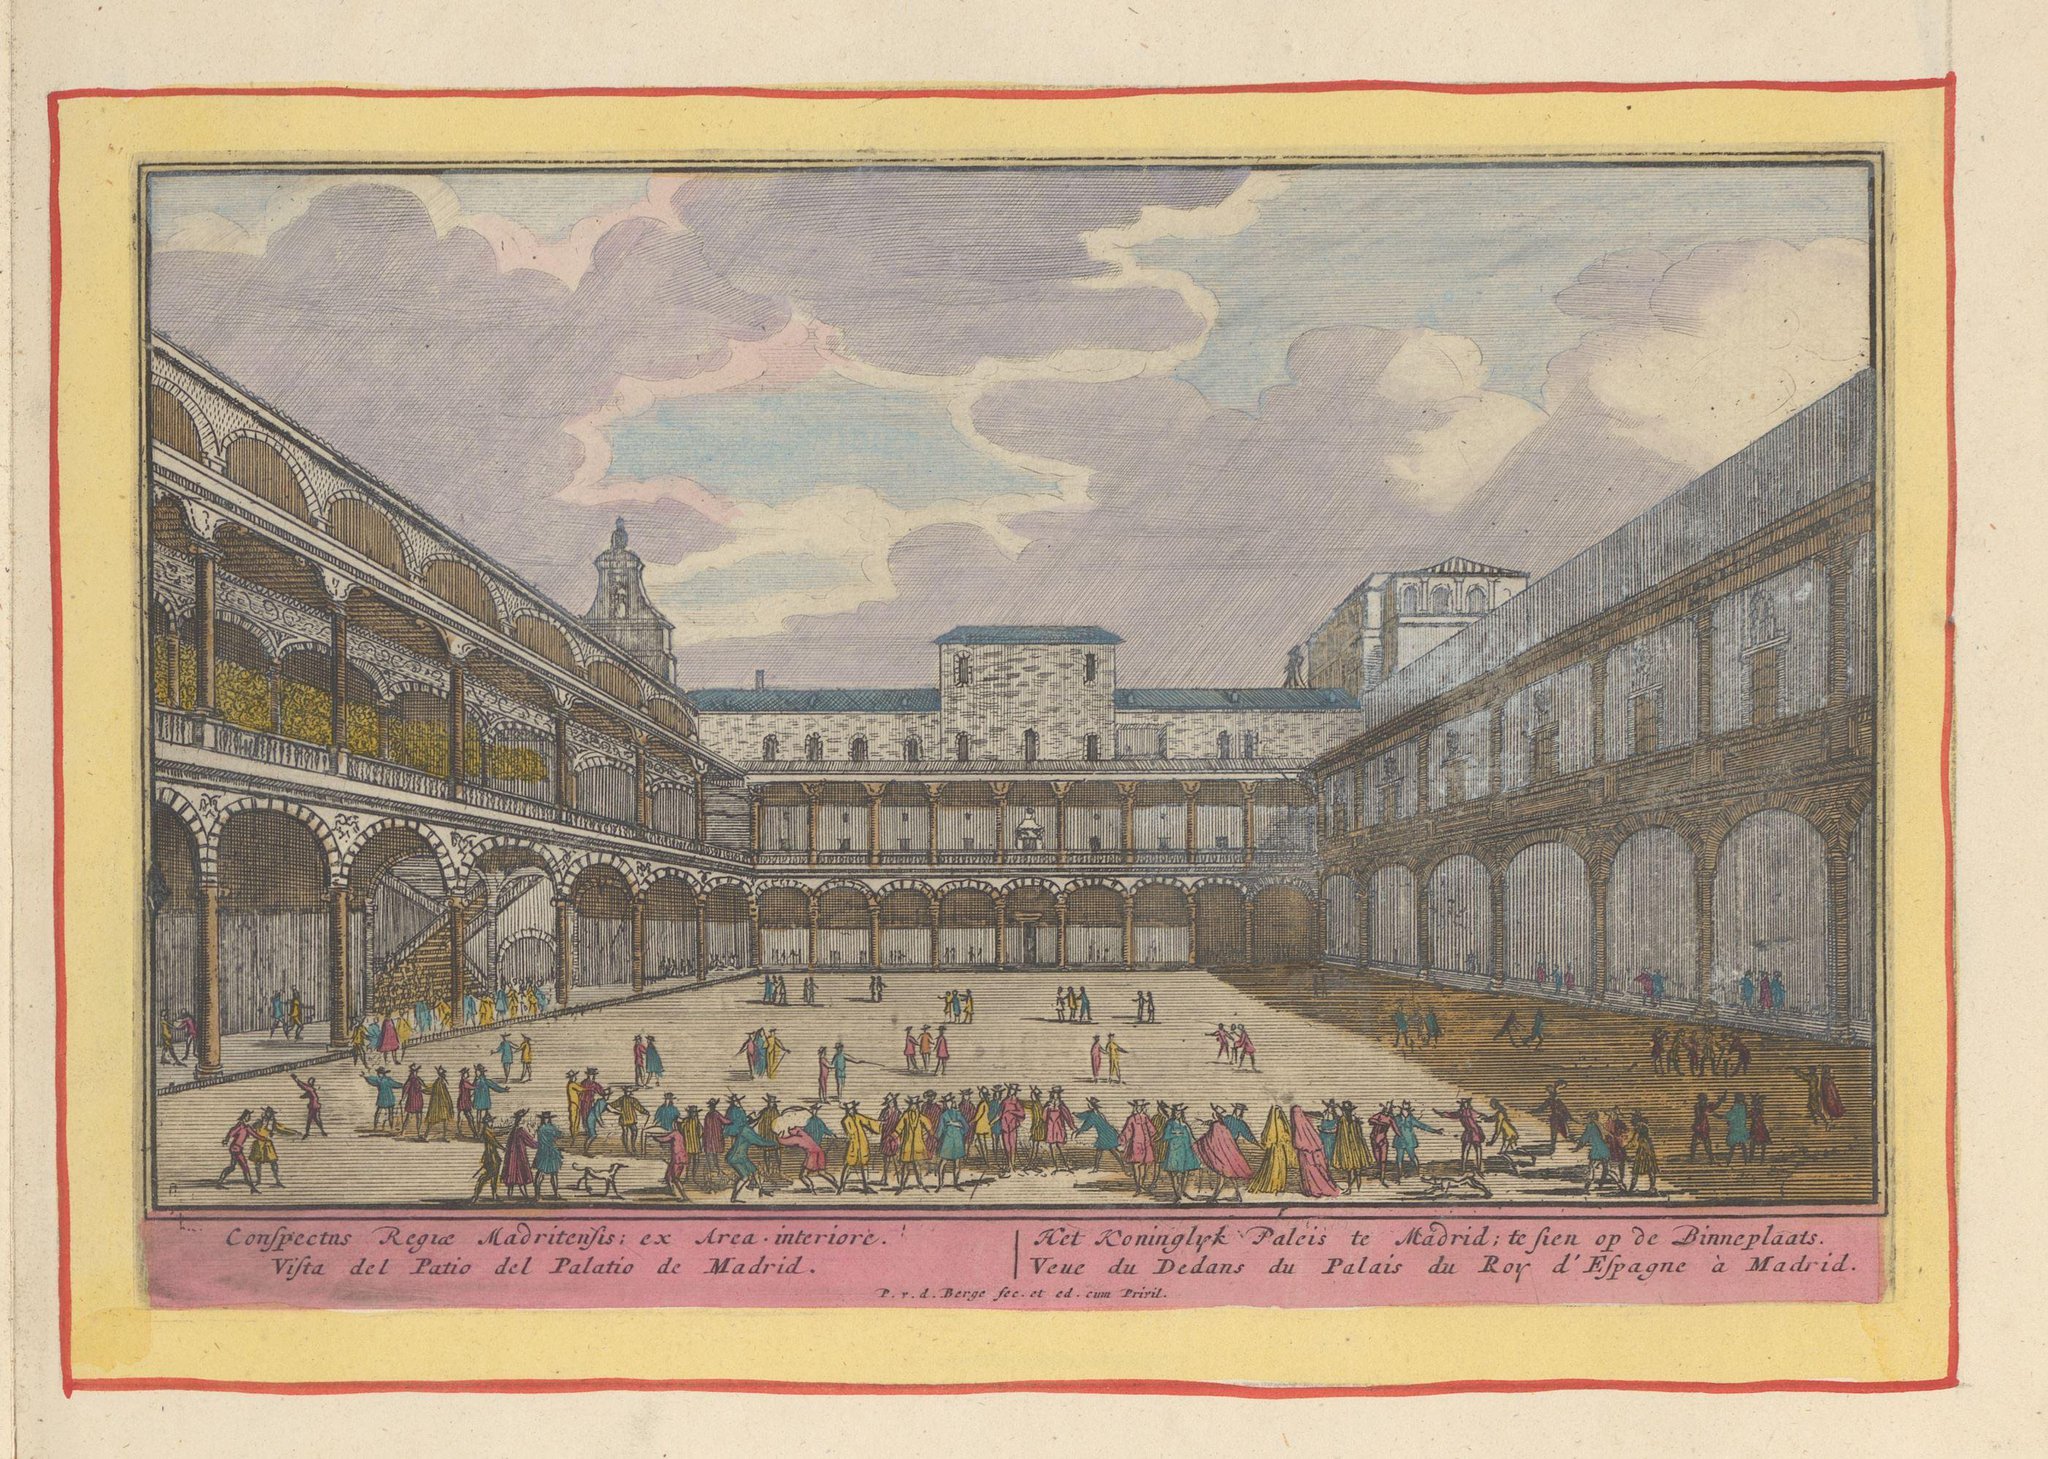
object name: album leaf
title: Het Koninglyk Paleis te Madrid; te sien op de Binneplaats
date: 1694-1737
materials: paper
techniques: etching, hand coloring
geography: the hague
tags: palace, courtyard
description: Prent uit: Theatrum Hispaniæ, exhibens regni urbes, villas ac viridaria magis illustria. Het aanmerkelykste en voortreffelykste in Spanjen (...). Amsterdam: Pieter van den Berge, ca. 1694-1737.